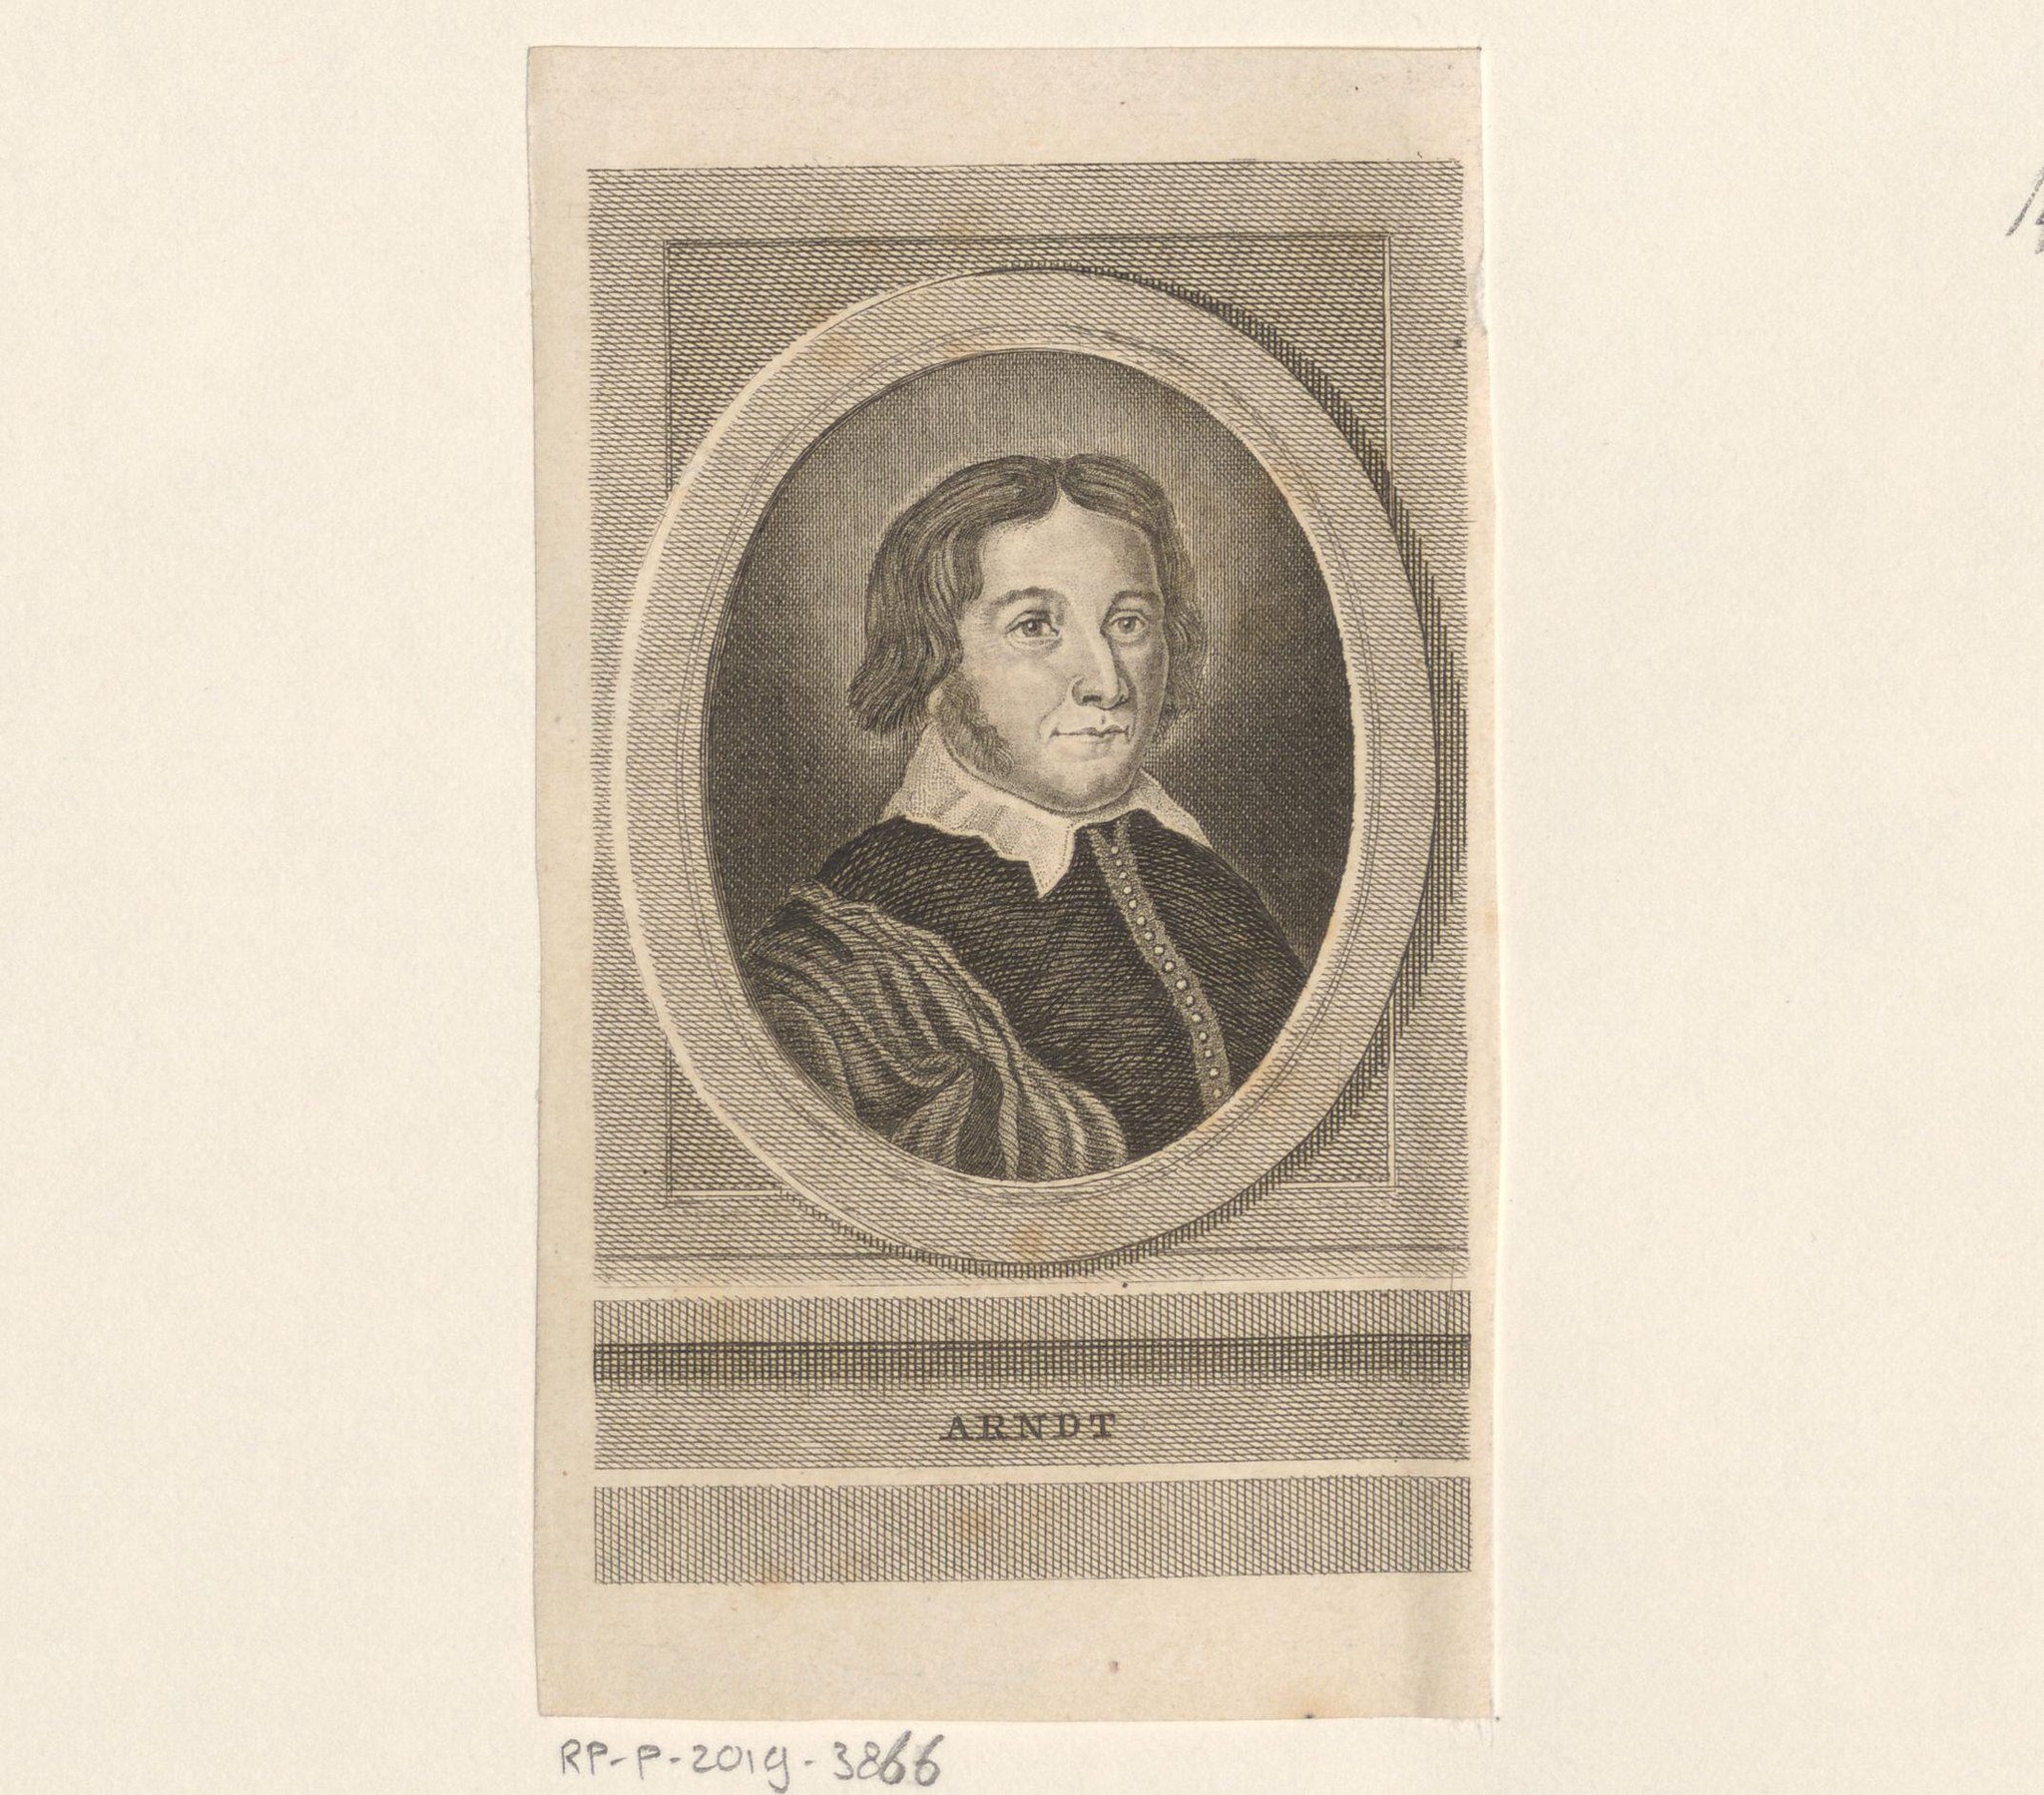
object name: print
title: Portret van Ernst Moritz Arndt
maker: Anonymous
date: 1800-1849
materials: paper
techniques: etching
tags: historical persons